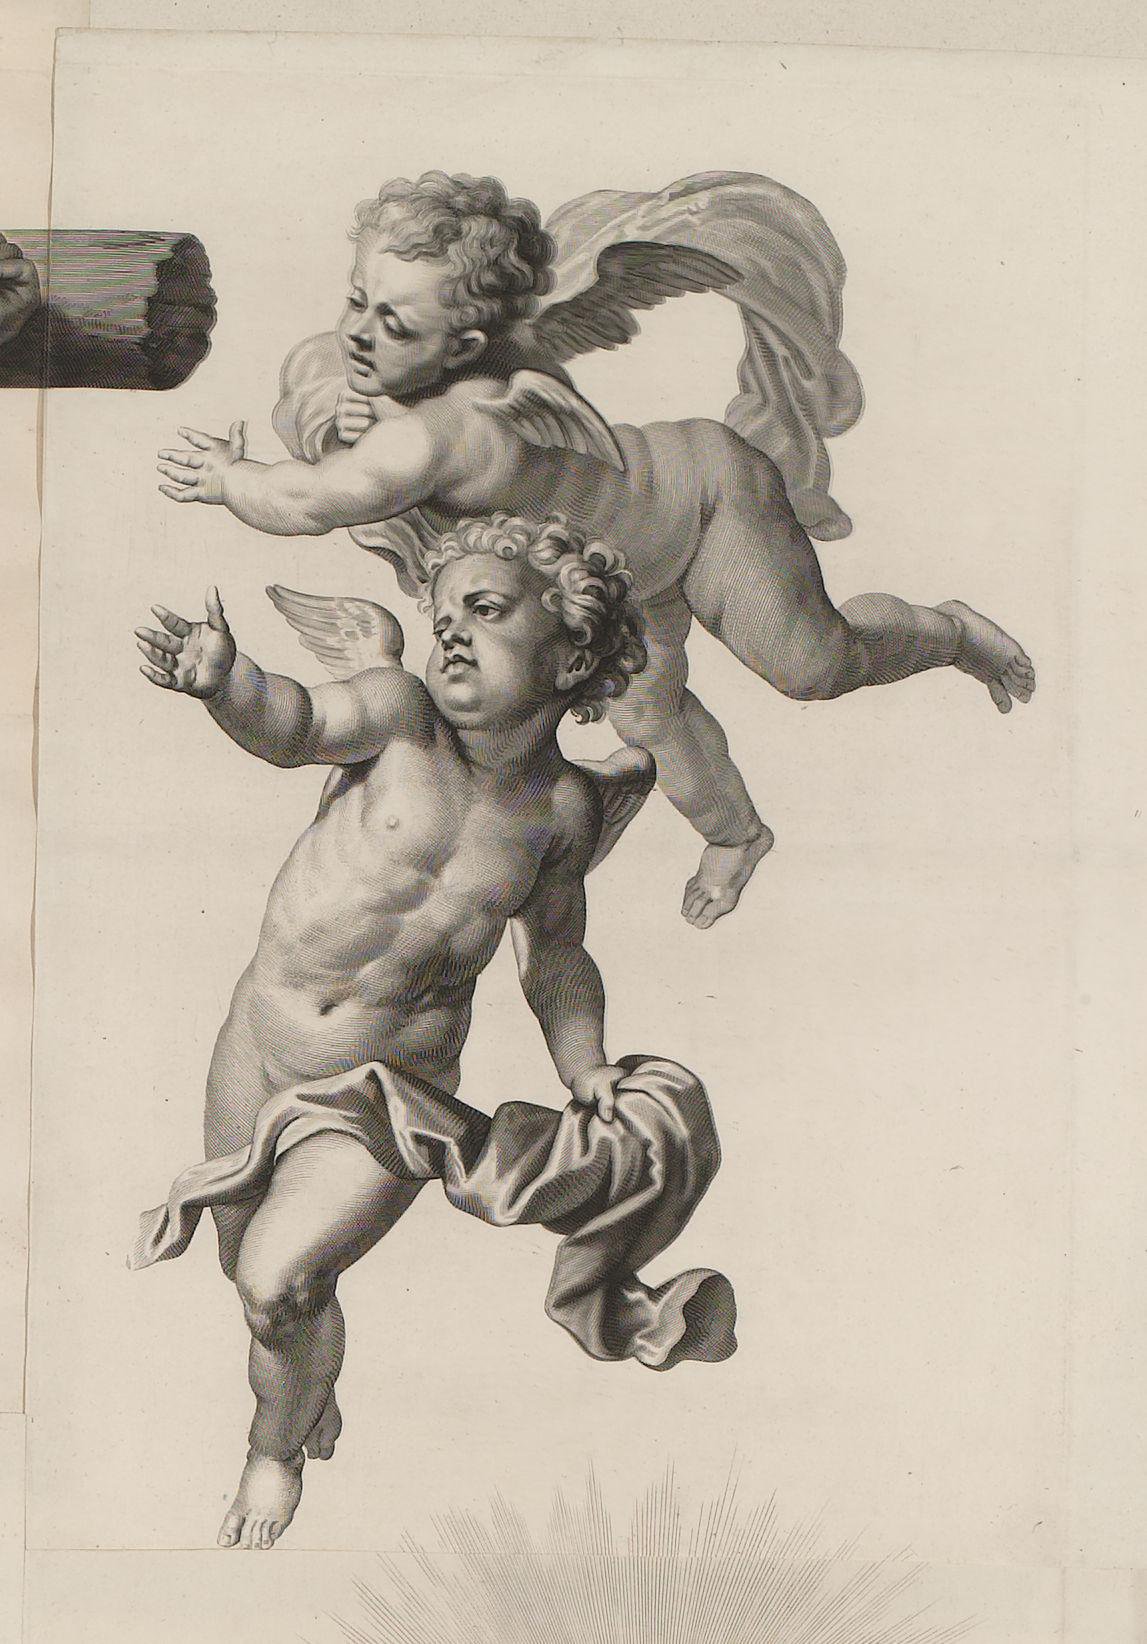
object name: print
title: Gekruisigde Christus met Maria, Johannes en Maria Magdelena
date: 1650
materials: paper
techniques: engraving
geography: antwerp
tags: crucified christ with mary, john, and mary magdalene, cupids: 'amores', 'amoretti', 'putti'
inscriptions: collector's mark: Lugt 240, collector's mark: Lugt 1838